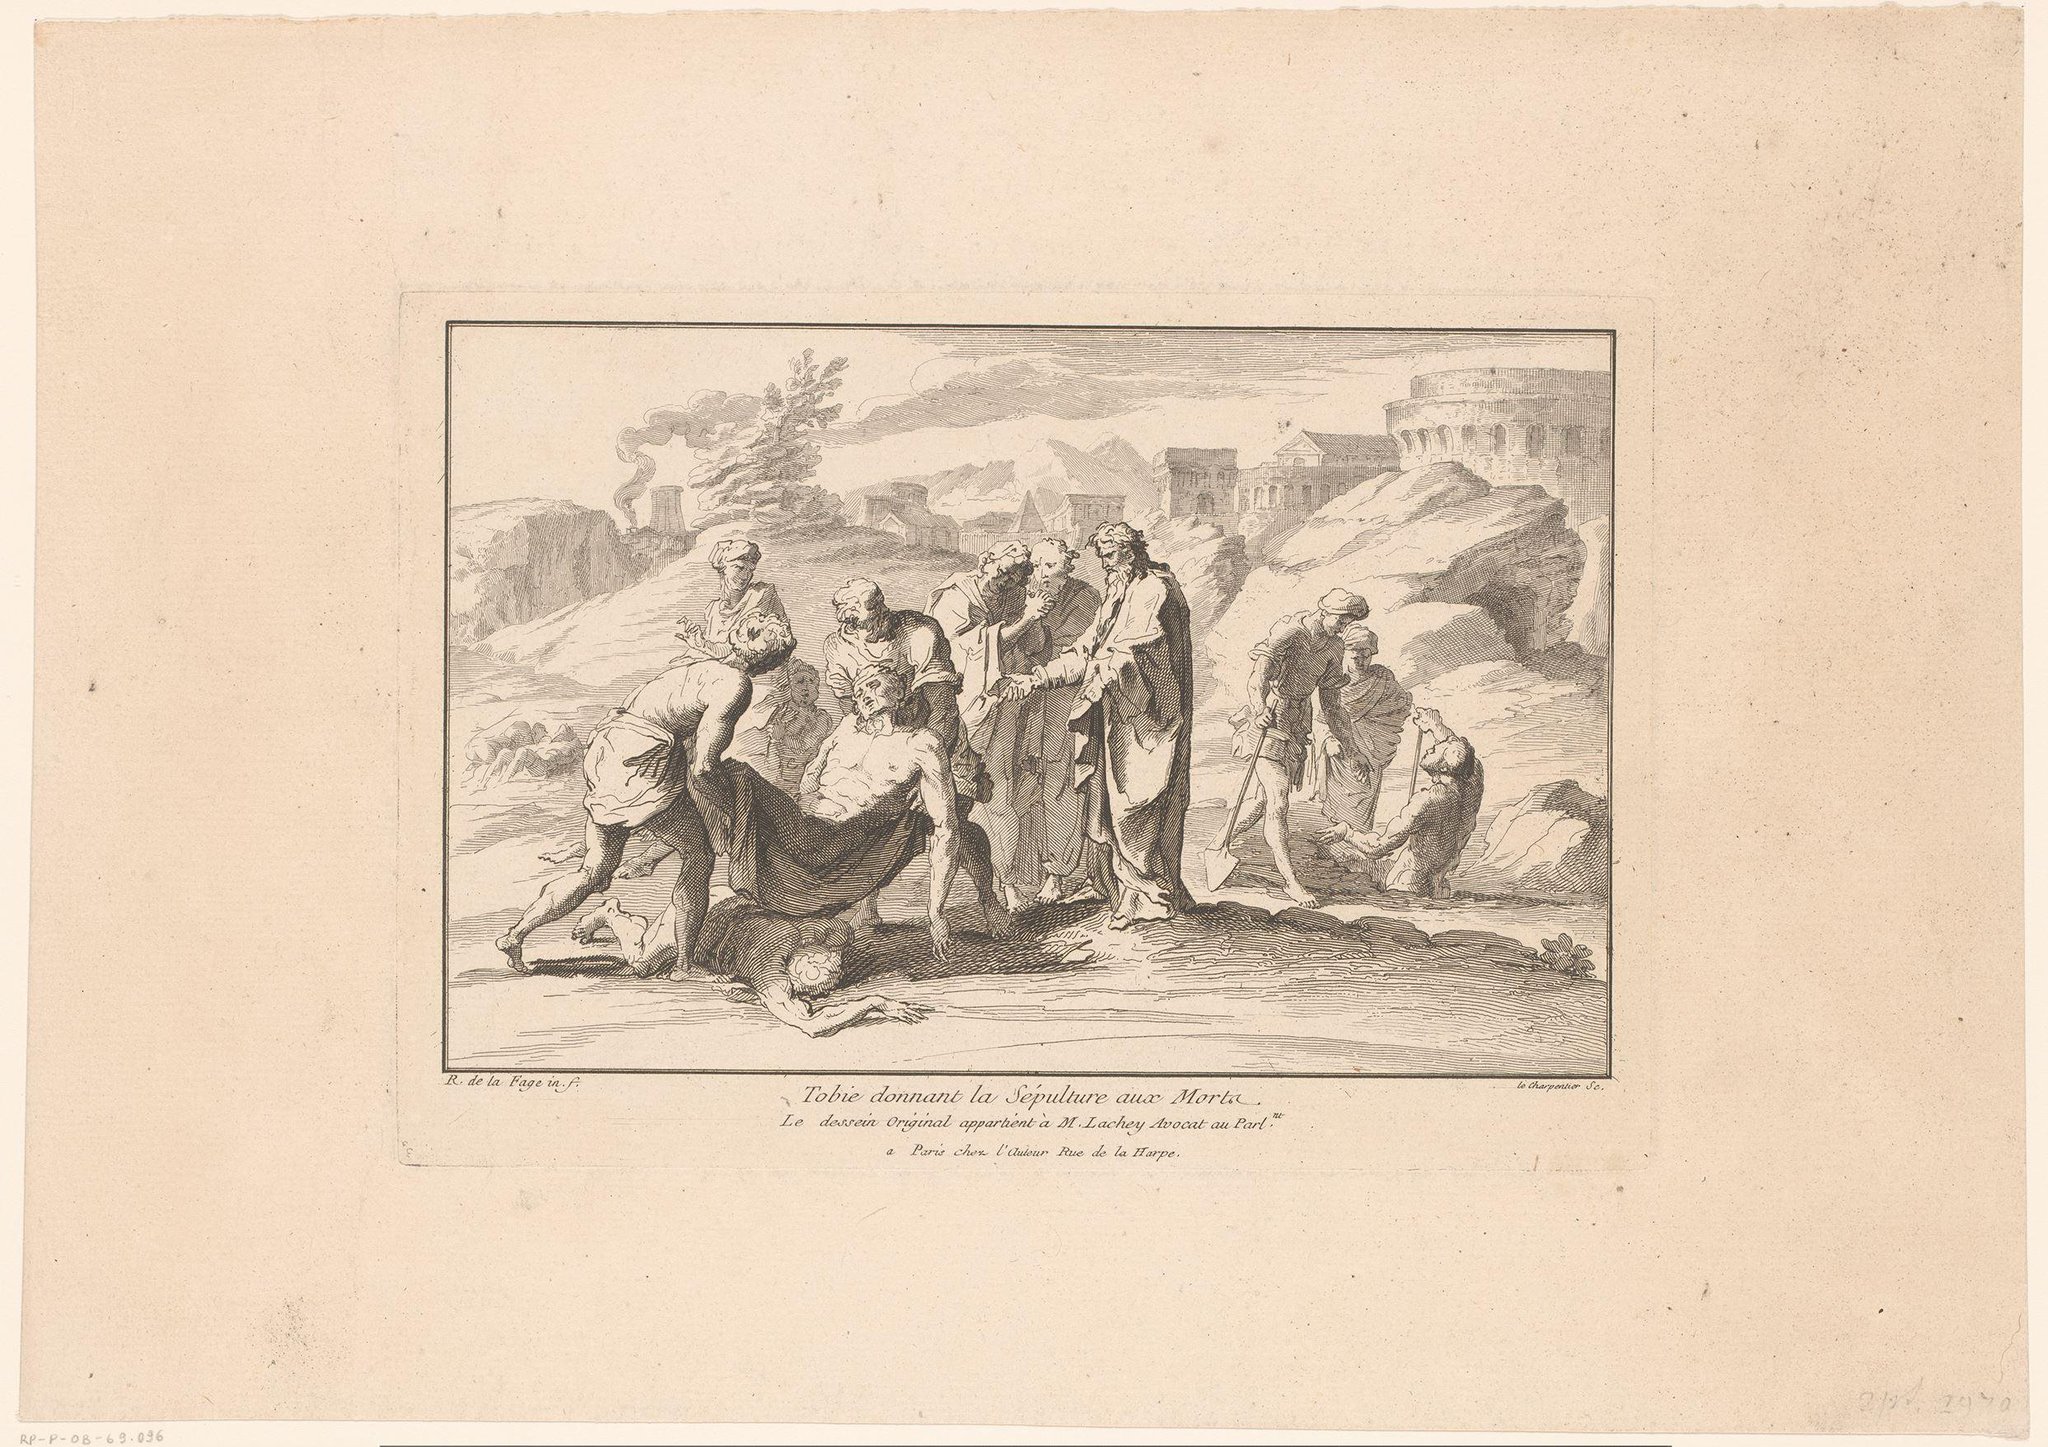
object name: print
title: Tobie donnant la Sépulture aux Mort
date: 1743-1770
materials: paper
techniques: engraving, etching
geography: paris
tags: tobit buries the dead in secret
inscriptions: collector's mark: Lugt 2165